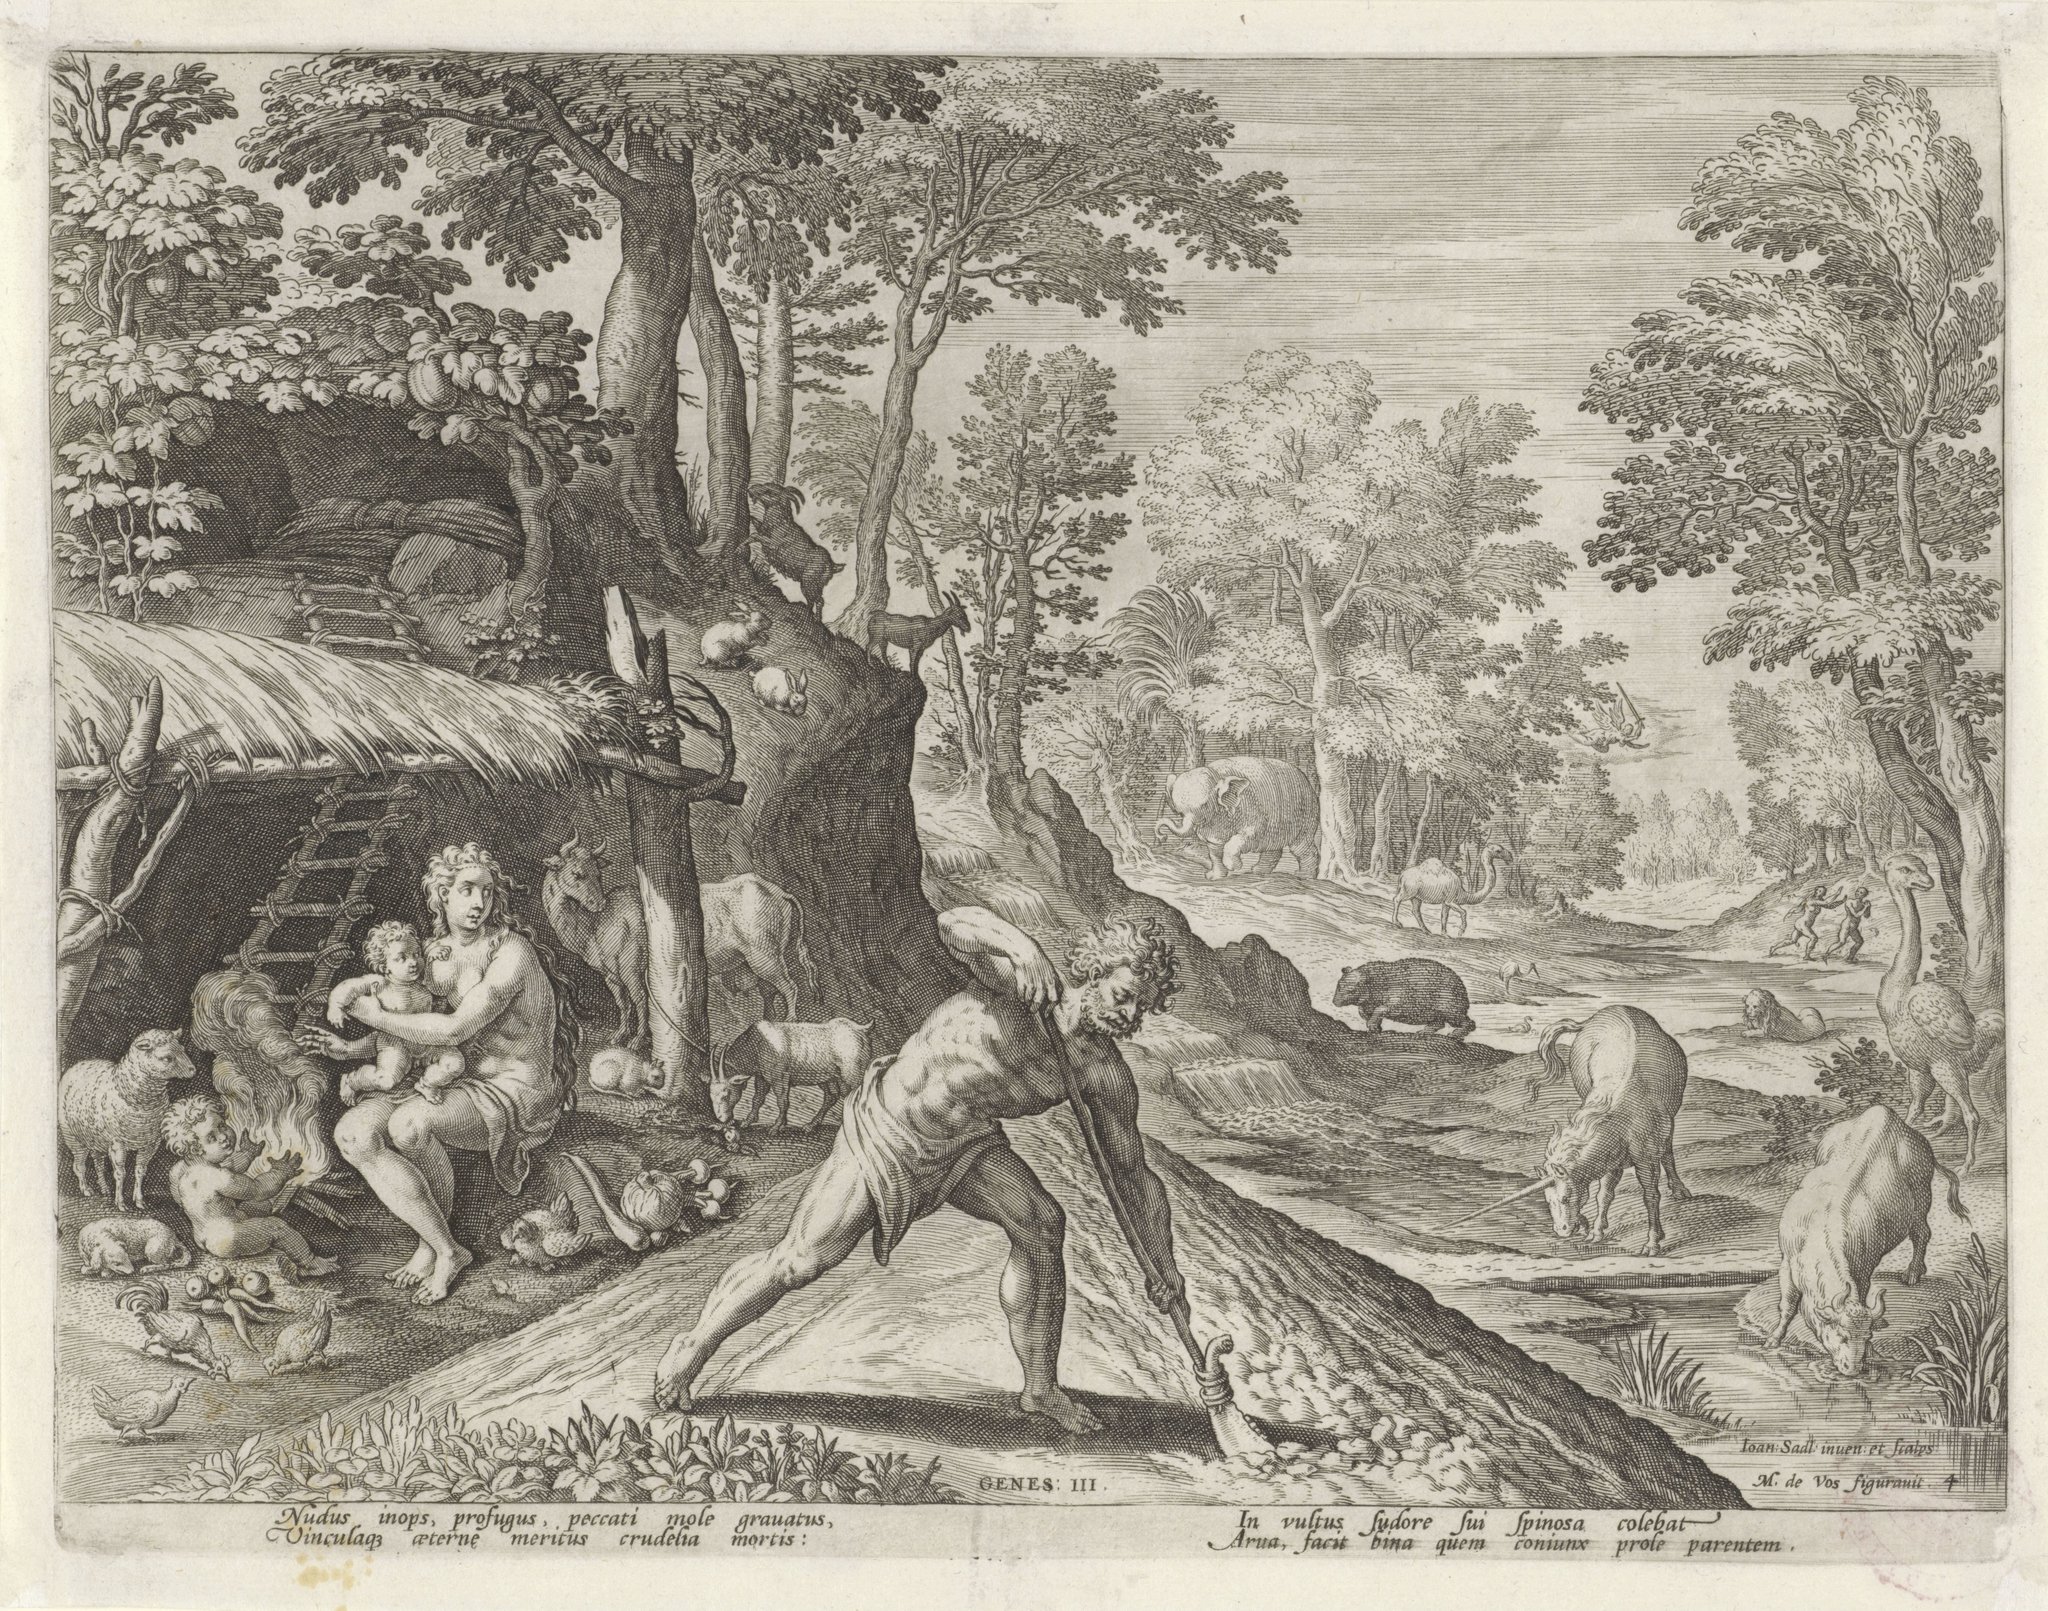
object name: print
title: Geschiedenis van de familie van Kaïn / Over goede en slechte werkzaamheden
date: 1583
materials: paper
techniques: engraving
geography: antwerp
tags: adam (and eve) engaged in agricultural activities, the labours of adam and eve; infancy of cain and abel (genesis 4:1-2), spading ~ soil cultivation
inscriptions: collector's mark: Lugt 240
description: Adam en Eva en hun kinderen Kaïn en Abel in de wildernis buiten het Aards Paradijs. Adam bewerkt de grond terwijl Eva Abel de borst geeft. Kaïn warmt zich aan het vuur. Rondom hen verschillende dieren. De prent heeft een Latijns onderschrift.